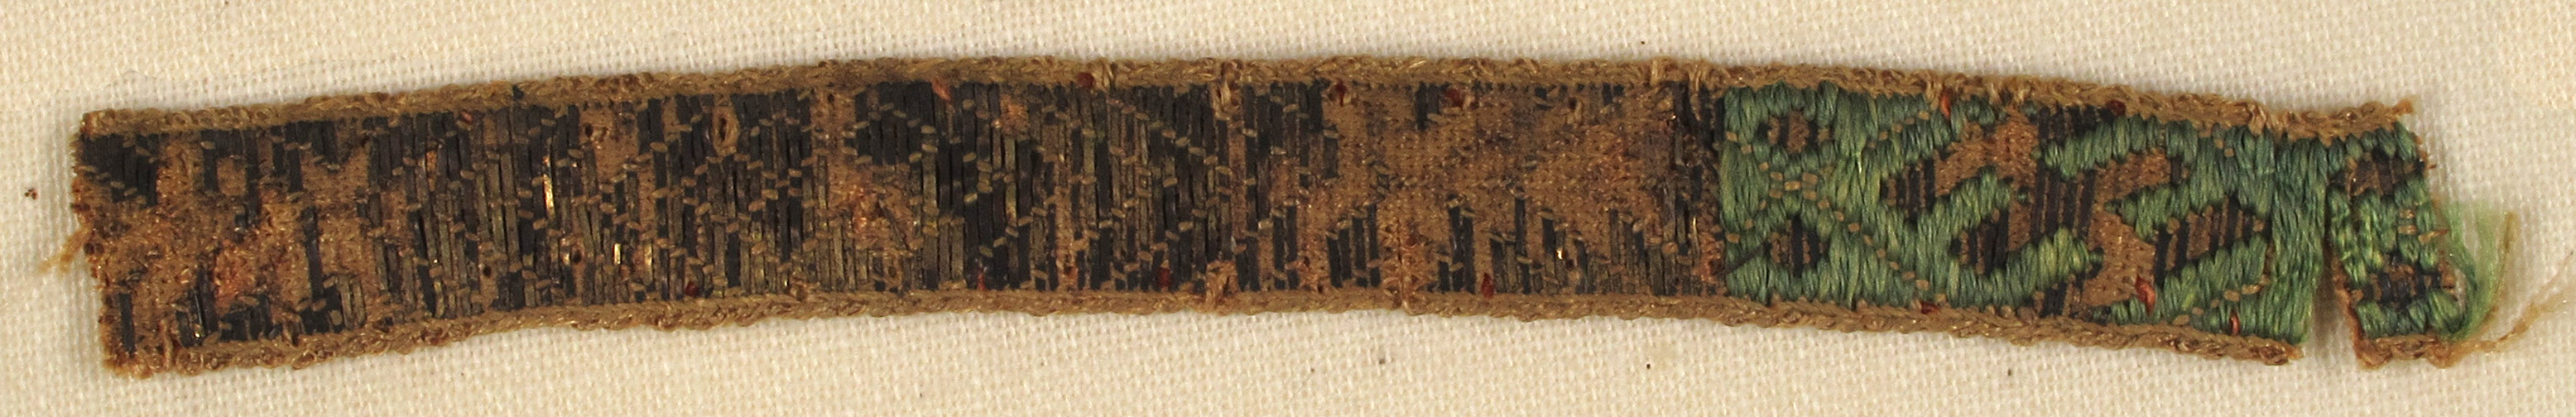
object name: ribbon fragment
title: Fragment of Ribbon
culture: italian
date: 1201-1400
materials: silver gilt, thread